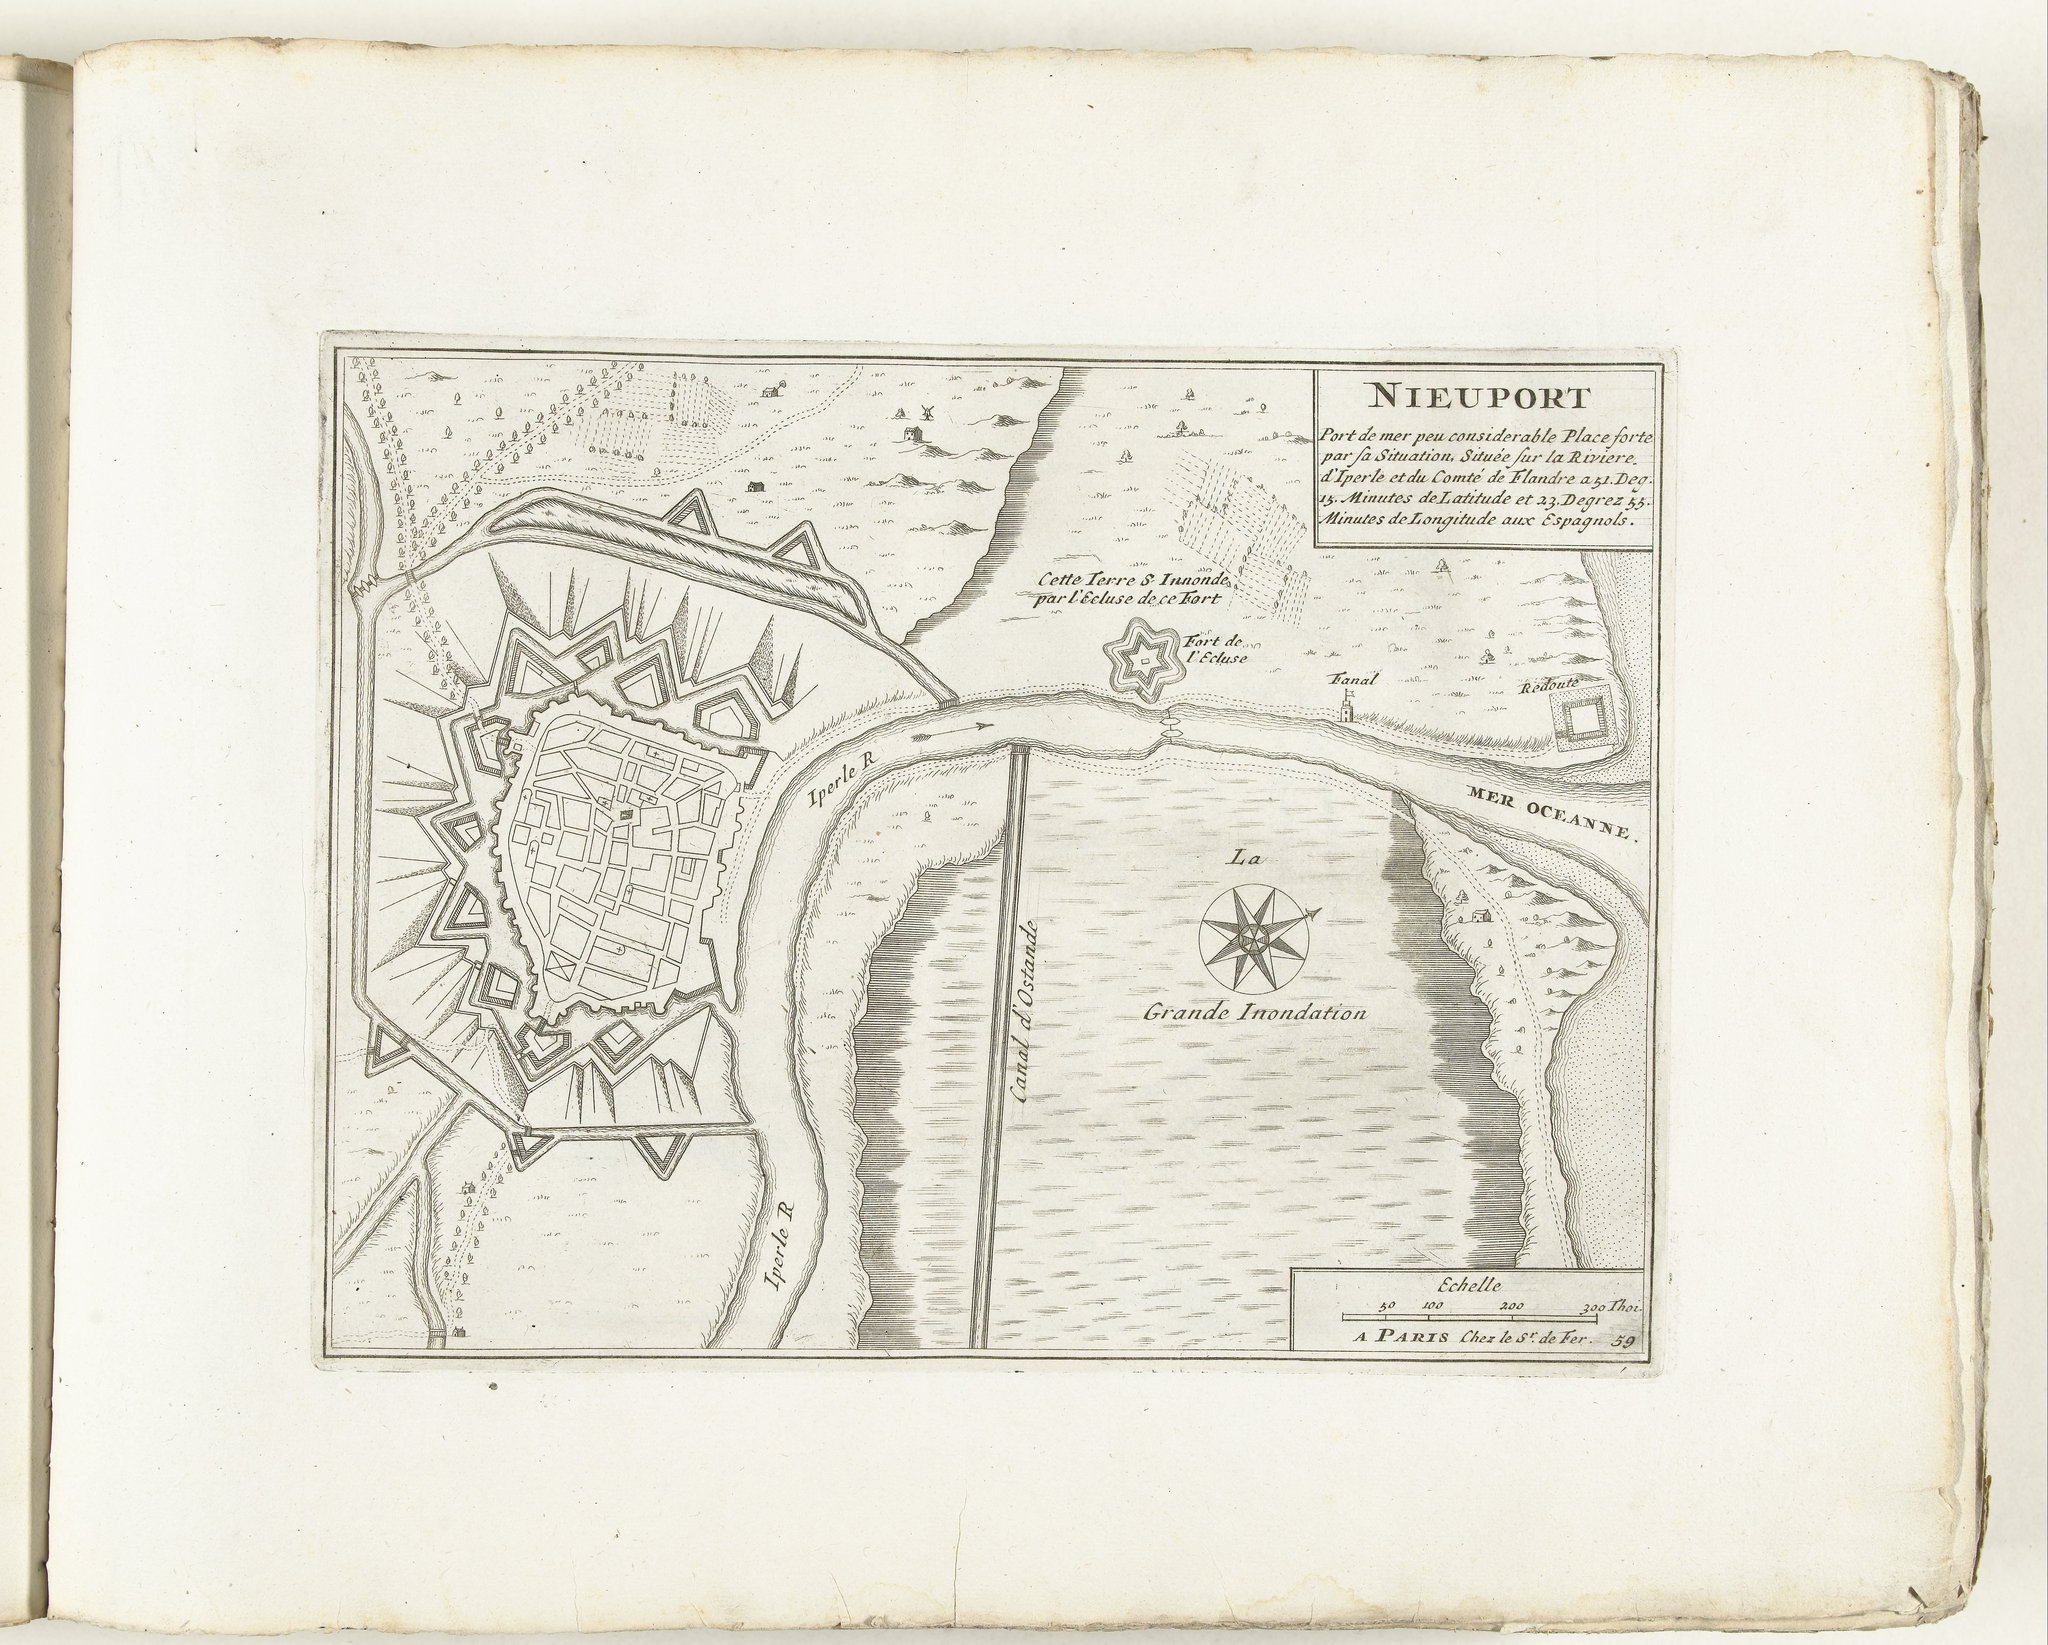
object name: map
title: Plattegrond van Nieuwpoort, ca. 1702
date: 1702-1703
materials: paper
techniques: engraving, etching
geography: paris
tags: fortress, maps of cities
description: Plattegrond van de verdedigingswerken om de stad Nieuwpoort. Plaat nr. 59 in het prentwerk bestaande in totaal uit 276 genummerde platen van vermaarde sterke steden en vestingen in het kader van de Spaanse Successieoorlog. Voor het merendeel zijn deze platen gekopieerd naar de anonieme Franse platen: in Les forces de l'Europe en in: Le theatre de la guerre, dans les Pays-Bas, beide oorspronkelijk uitgegeven door Nicolas de Fer te Parijs (1693-1697) in het kader van de Negenjarige Oorlog. Titel en opschriften in de plaat in het Frans.